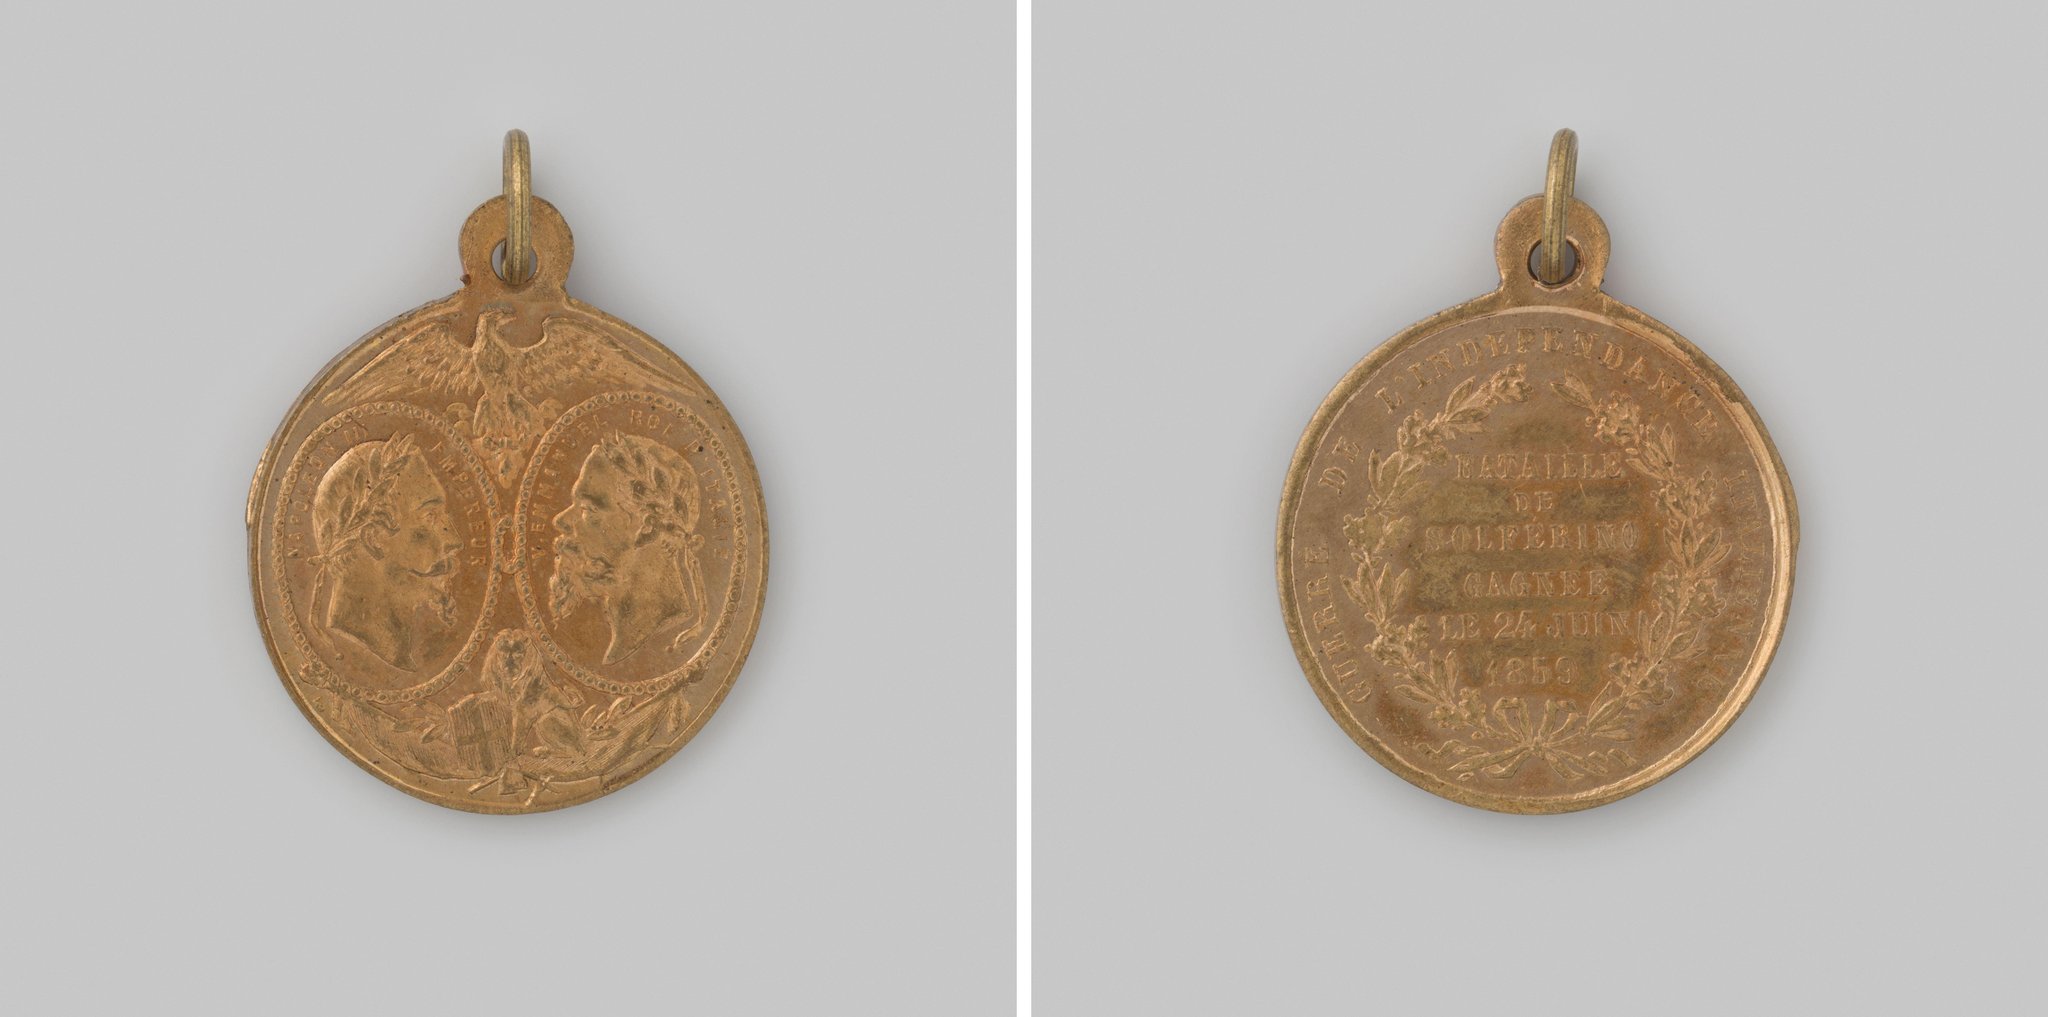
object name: history medal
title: Slag bij Solferino 1859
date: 1859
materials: brass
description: Vergulde penning met ring en draagoog, op de voorzijde twee medaillons met de portretten van Napoleon III en Victor Emanuel waartussen een Franse adelaar en een Italiaanse leeuw, op de keerzijde vijf regels tekst tussen samengebonden lauwer- en eikentakken, met omschrift.